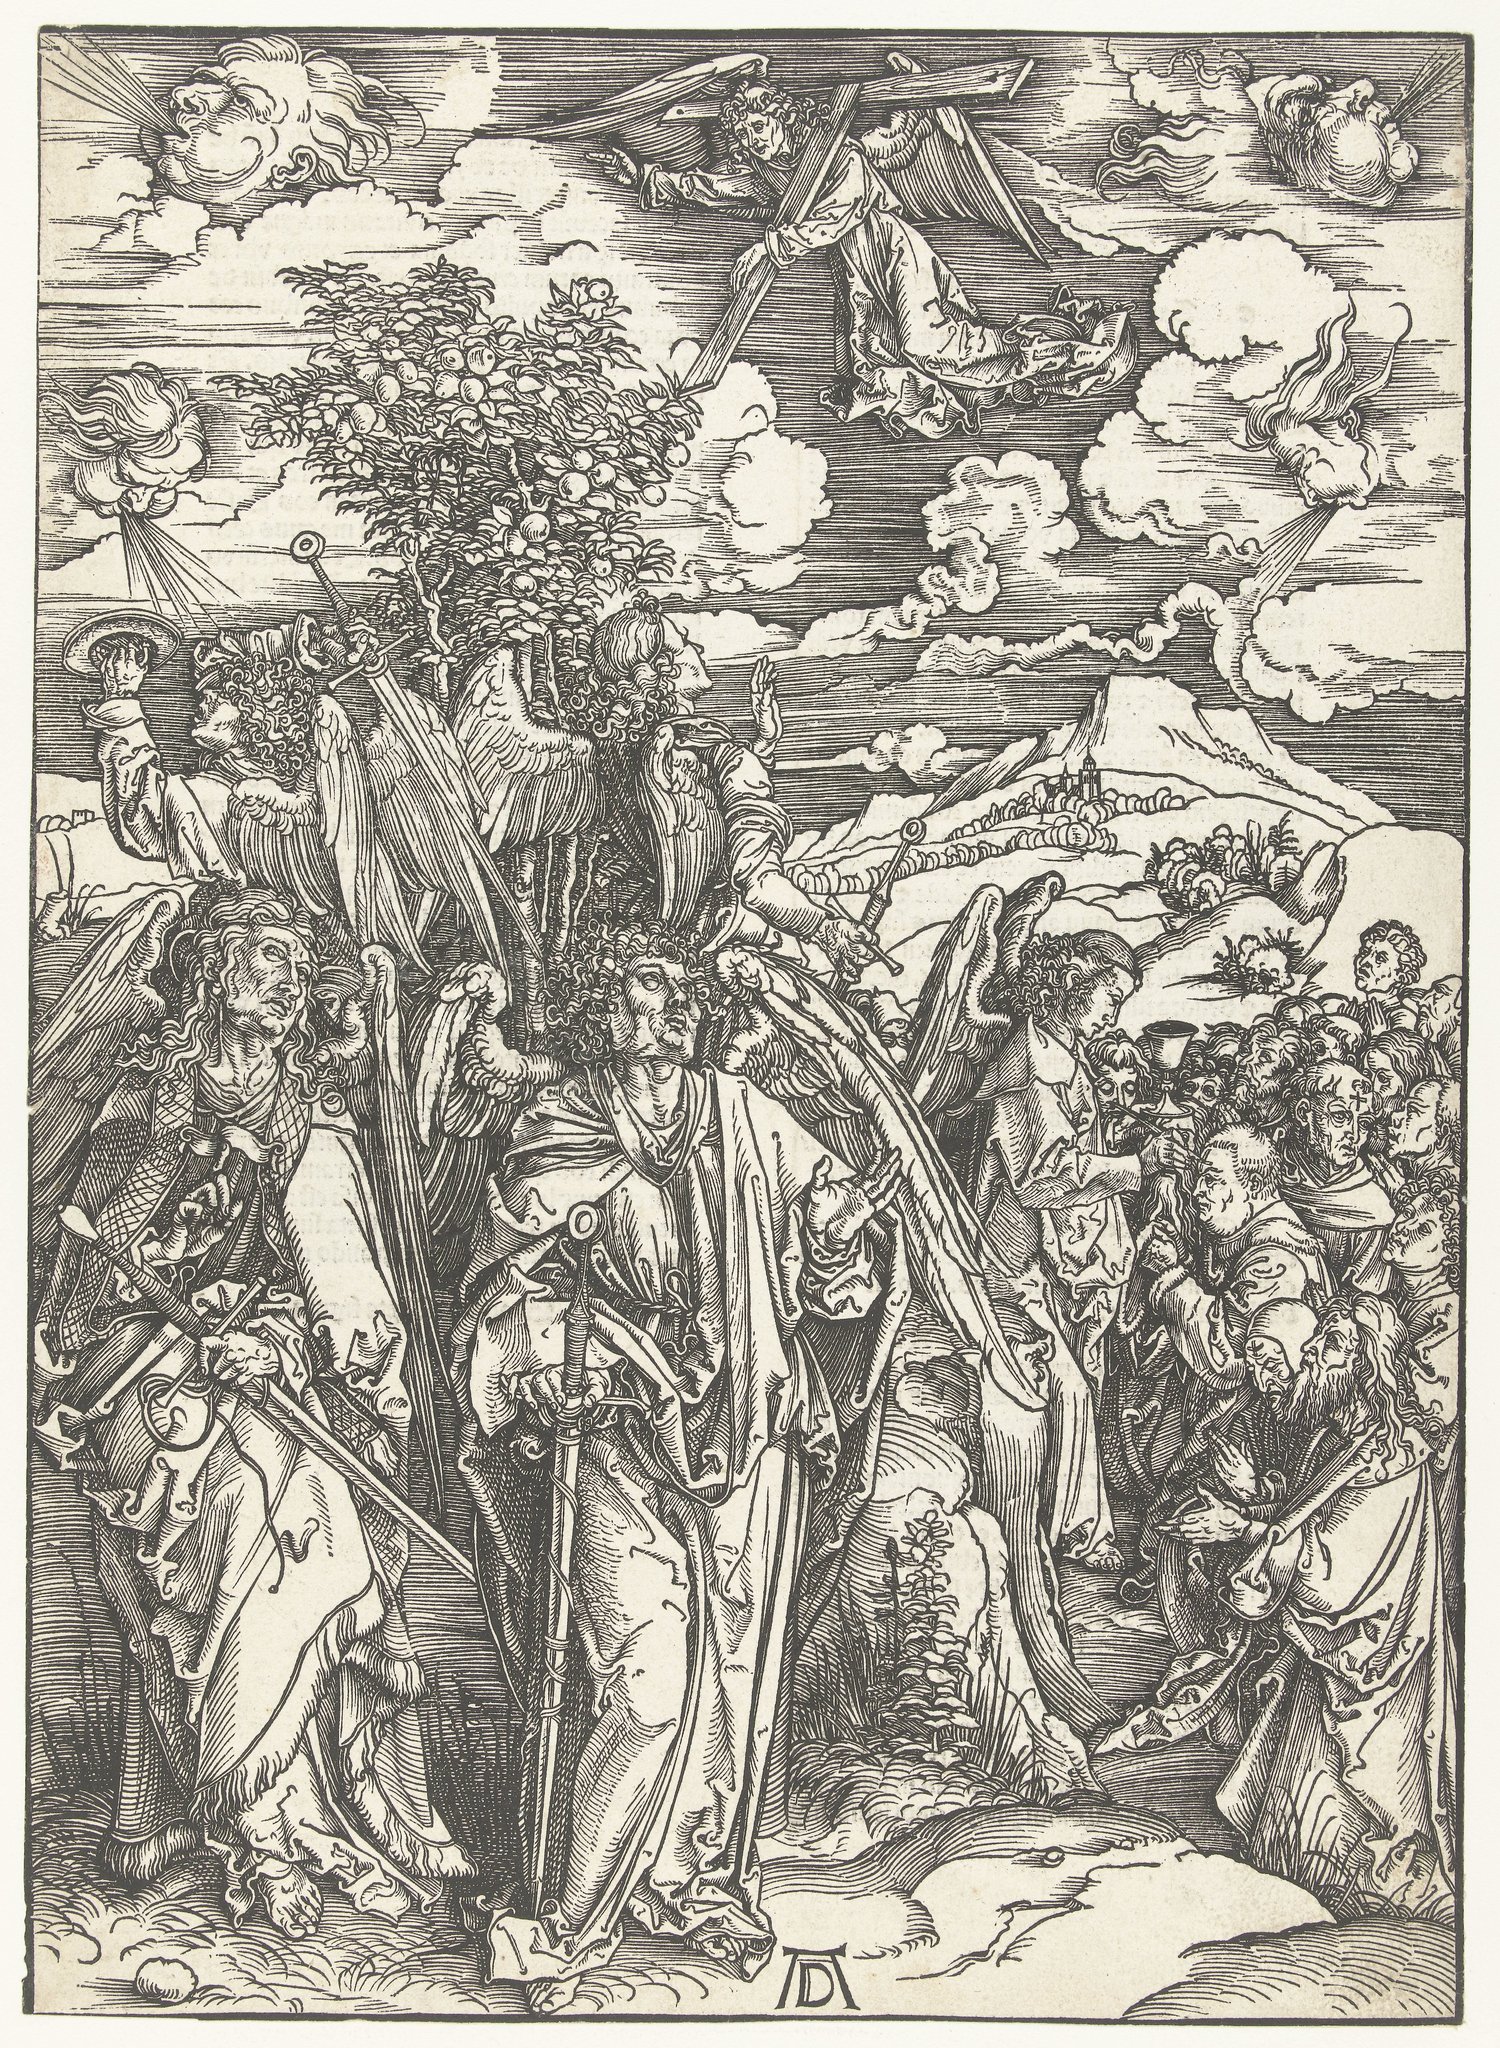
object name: print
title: Engelen houden de vier winden tegen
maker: albrecht dürer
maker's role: draughtsman, painter, print maker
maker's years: 1471-1528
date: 1497-1498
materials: paper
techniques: letterpress printing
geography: nuremberg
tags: the four winds are restrained by four angels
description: Vier engelen, linksonder, houden vier winden (in de vorm van vier blazende kopjes) tegen, terwijl een andere engel bij een aantal mensen een kruis op het voorhoofd tekent. Op versozijde Latijnse bijbeltekst in gotisch schrift in twee kolommen.